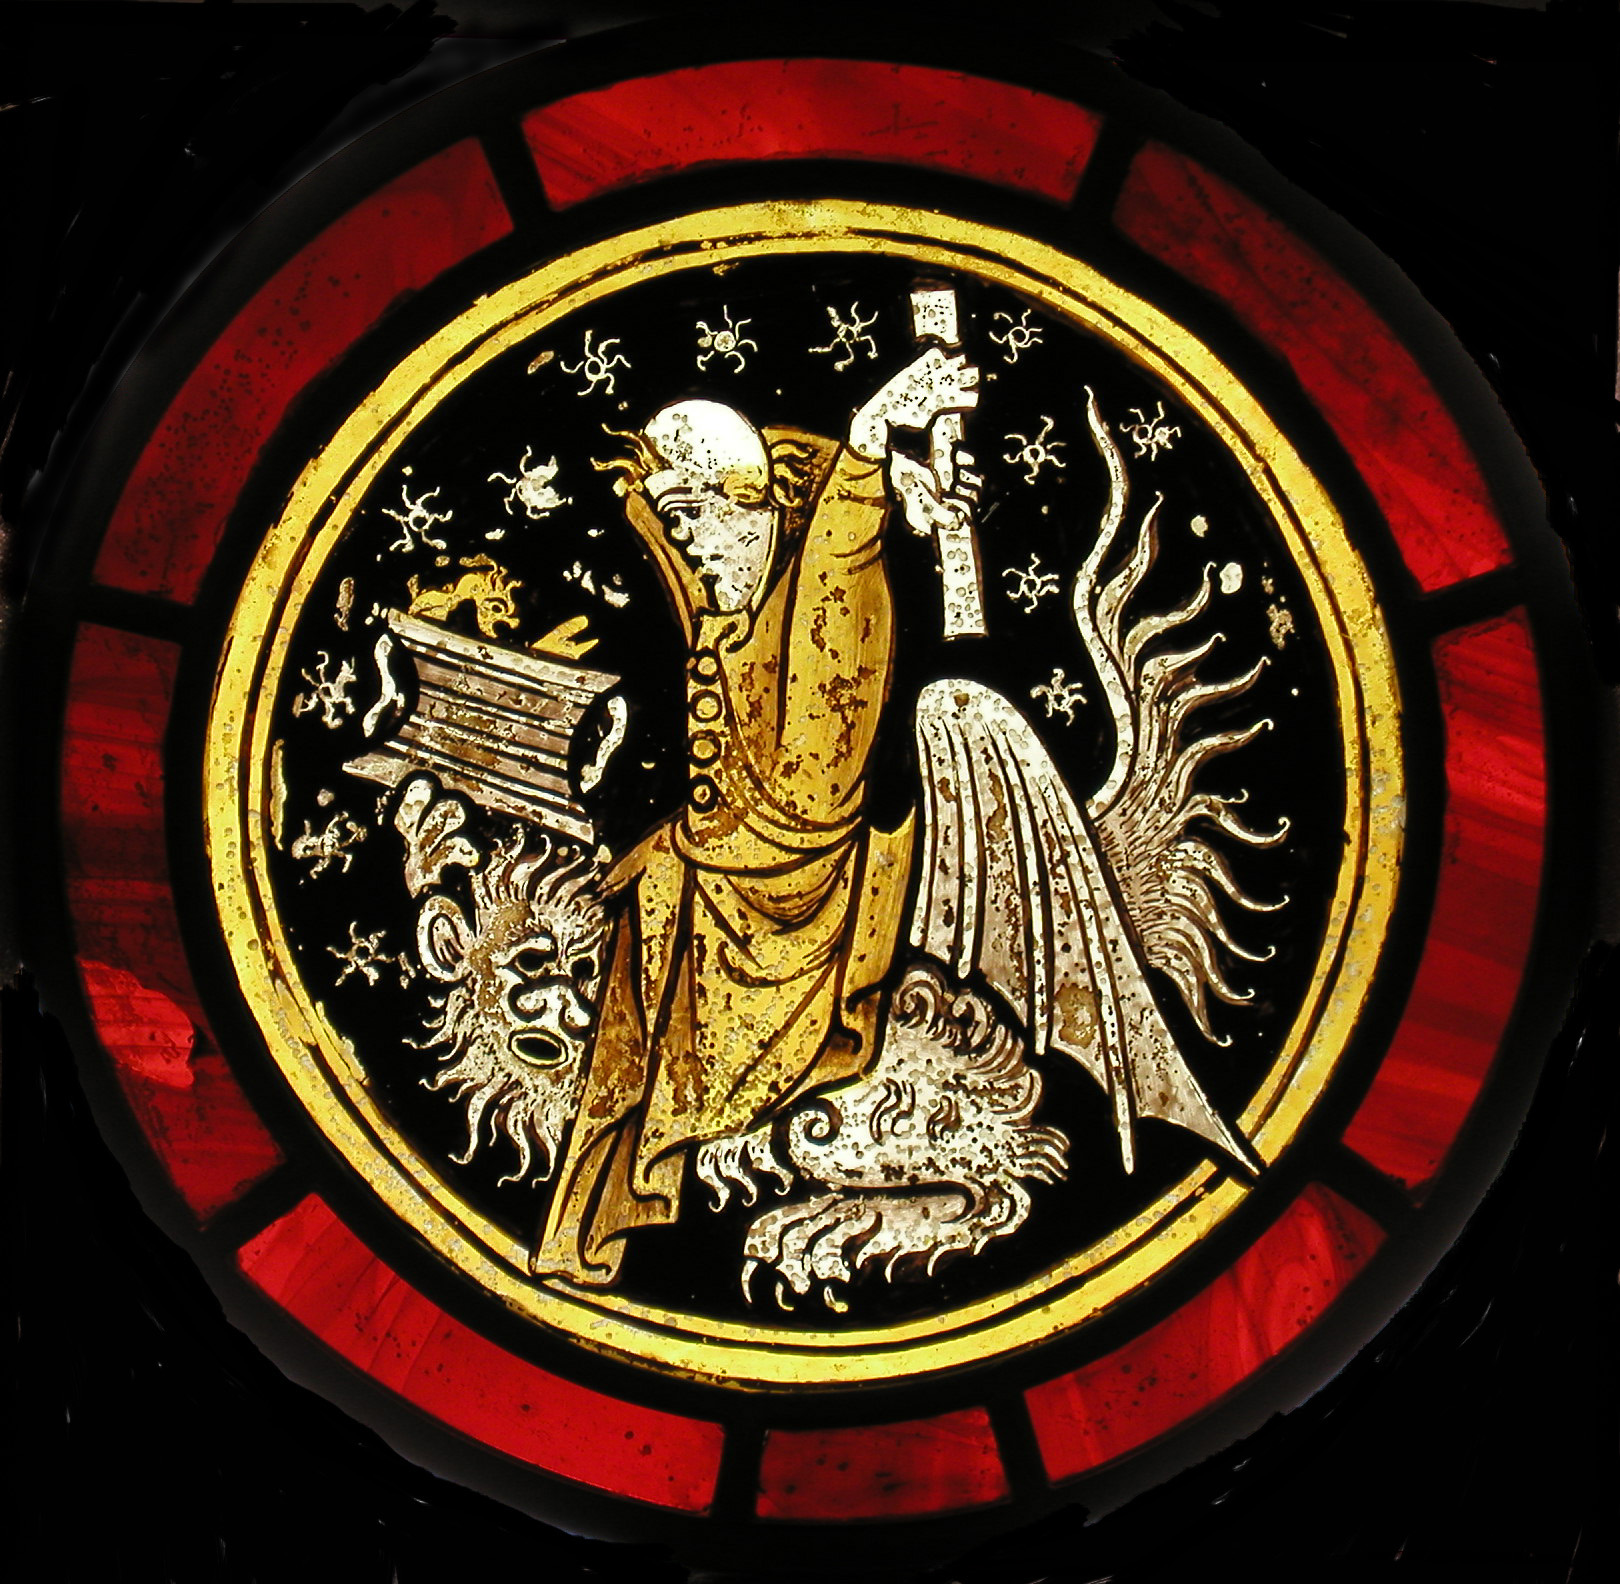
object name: roundel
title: Roundel with Grotesque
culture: british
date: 1320-1340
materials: glass, paint, pigment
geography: england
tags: dragons